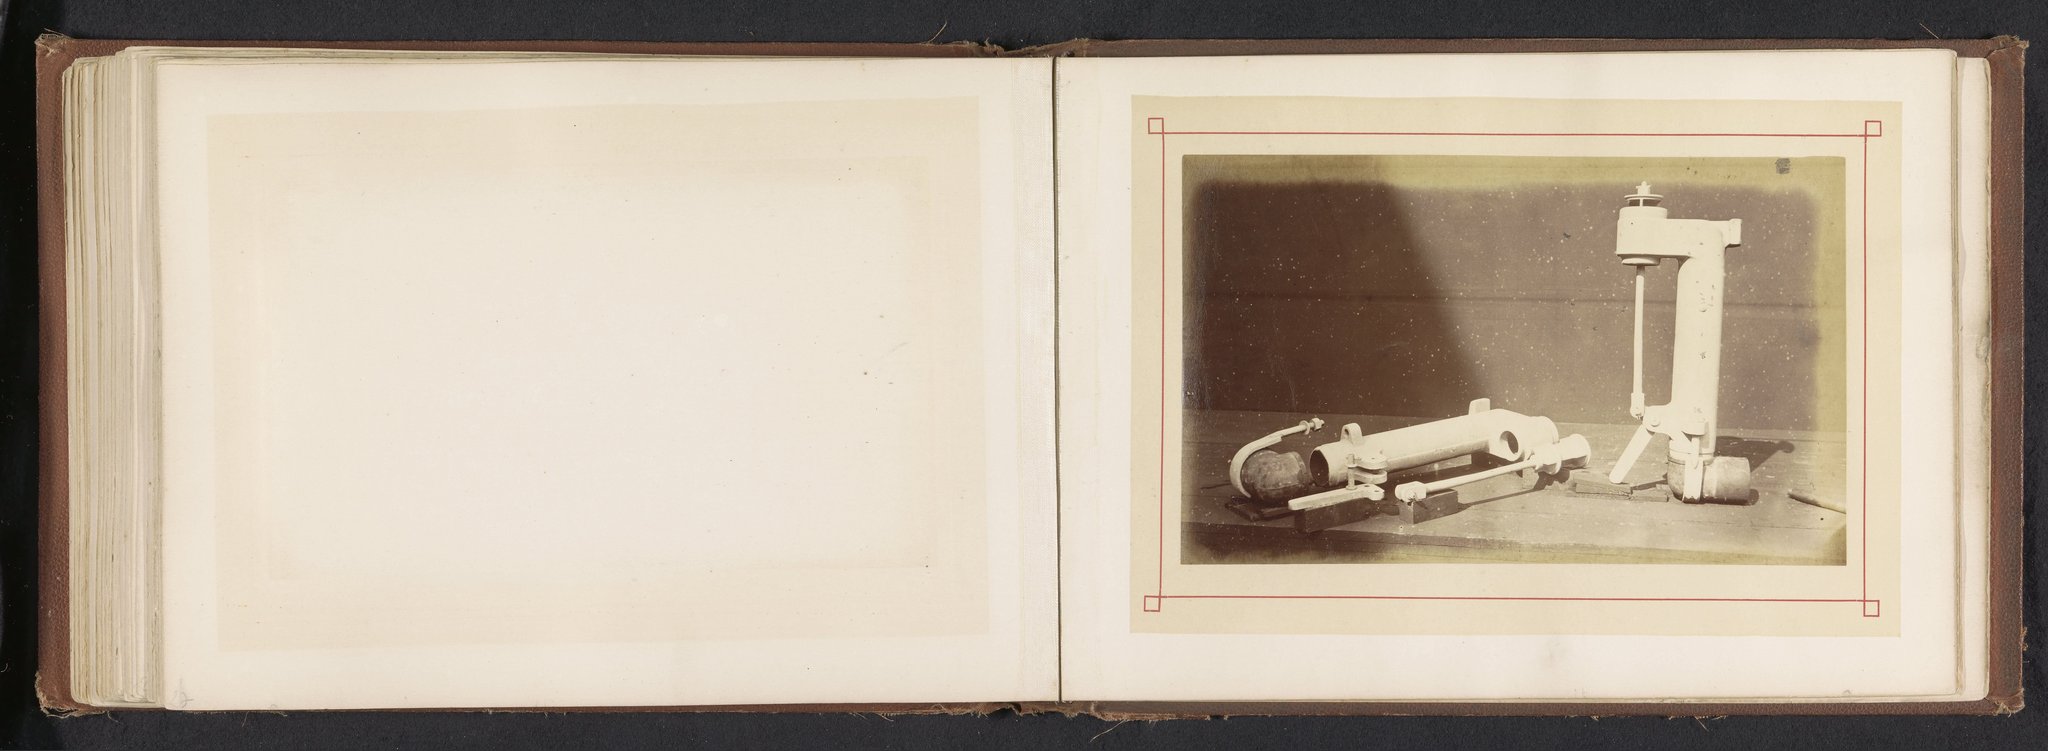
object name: photograph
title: Onderdelen van een stoomlocomotief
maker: george gardner rockwood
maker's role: fotograaf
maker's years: 1832-1911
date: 1861-1871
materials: photographic support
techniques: albumen print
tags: steam locomotive